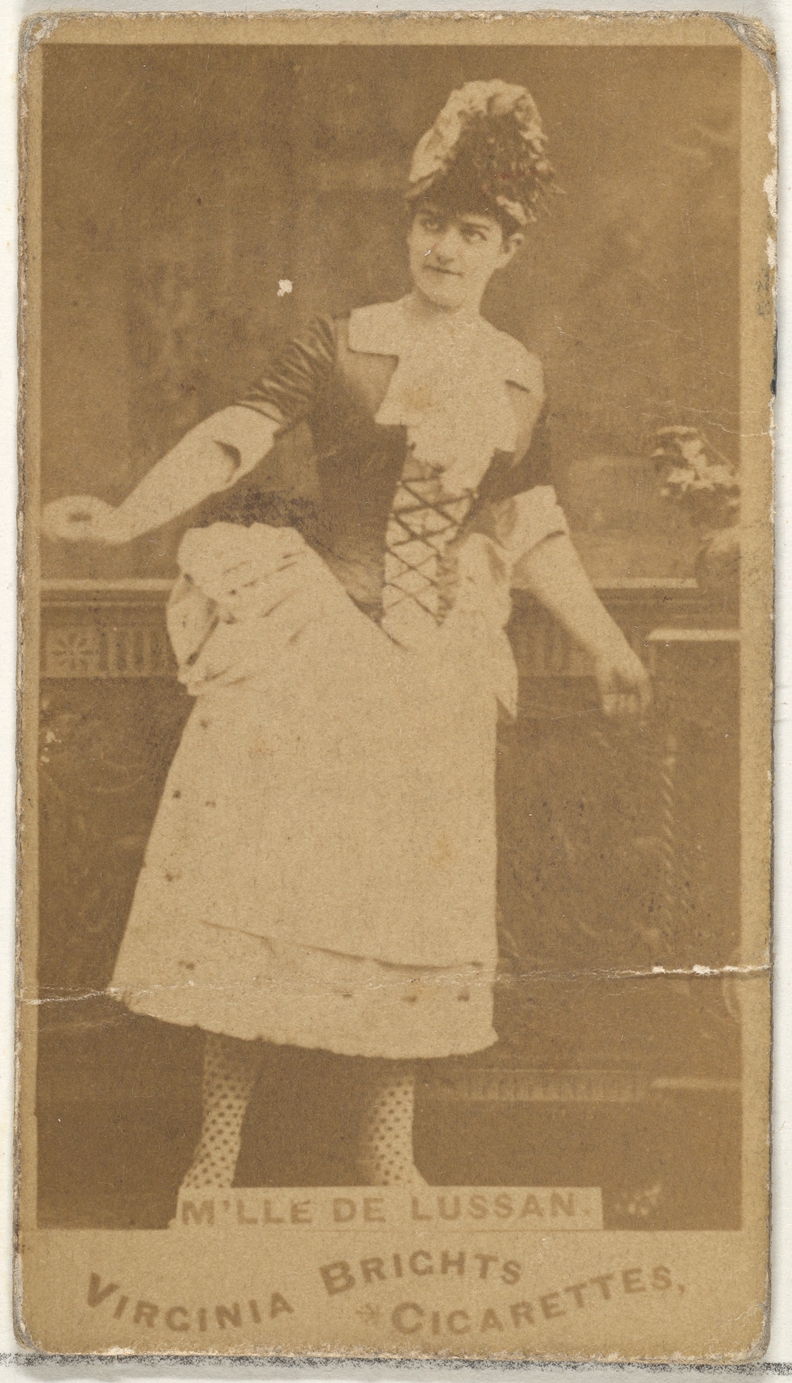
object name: photograph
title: M'lle de Lussan, from the Actors and Actresses series (N45, Type 1) for Virginia Brights Cigarettes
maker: allen & ginter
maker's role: publisher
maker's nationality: american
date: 1888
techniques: albumen silver print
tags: portraits,women,actresses